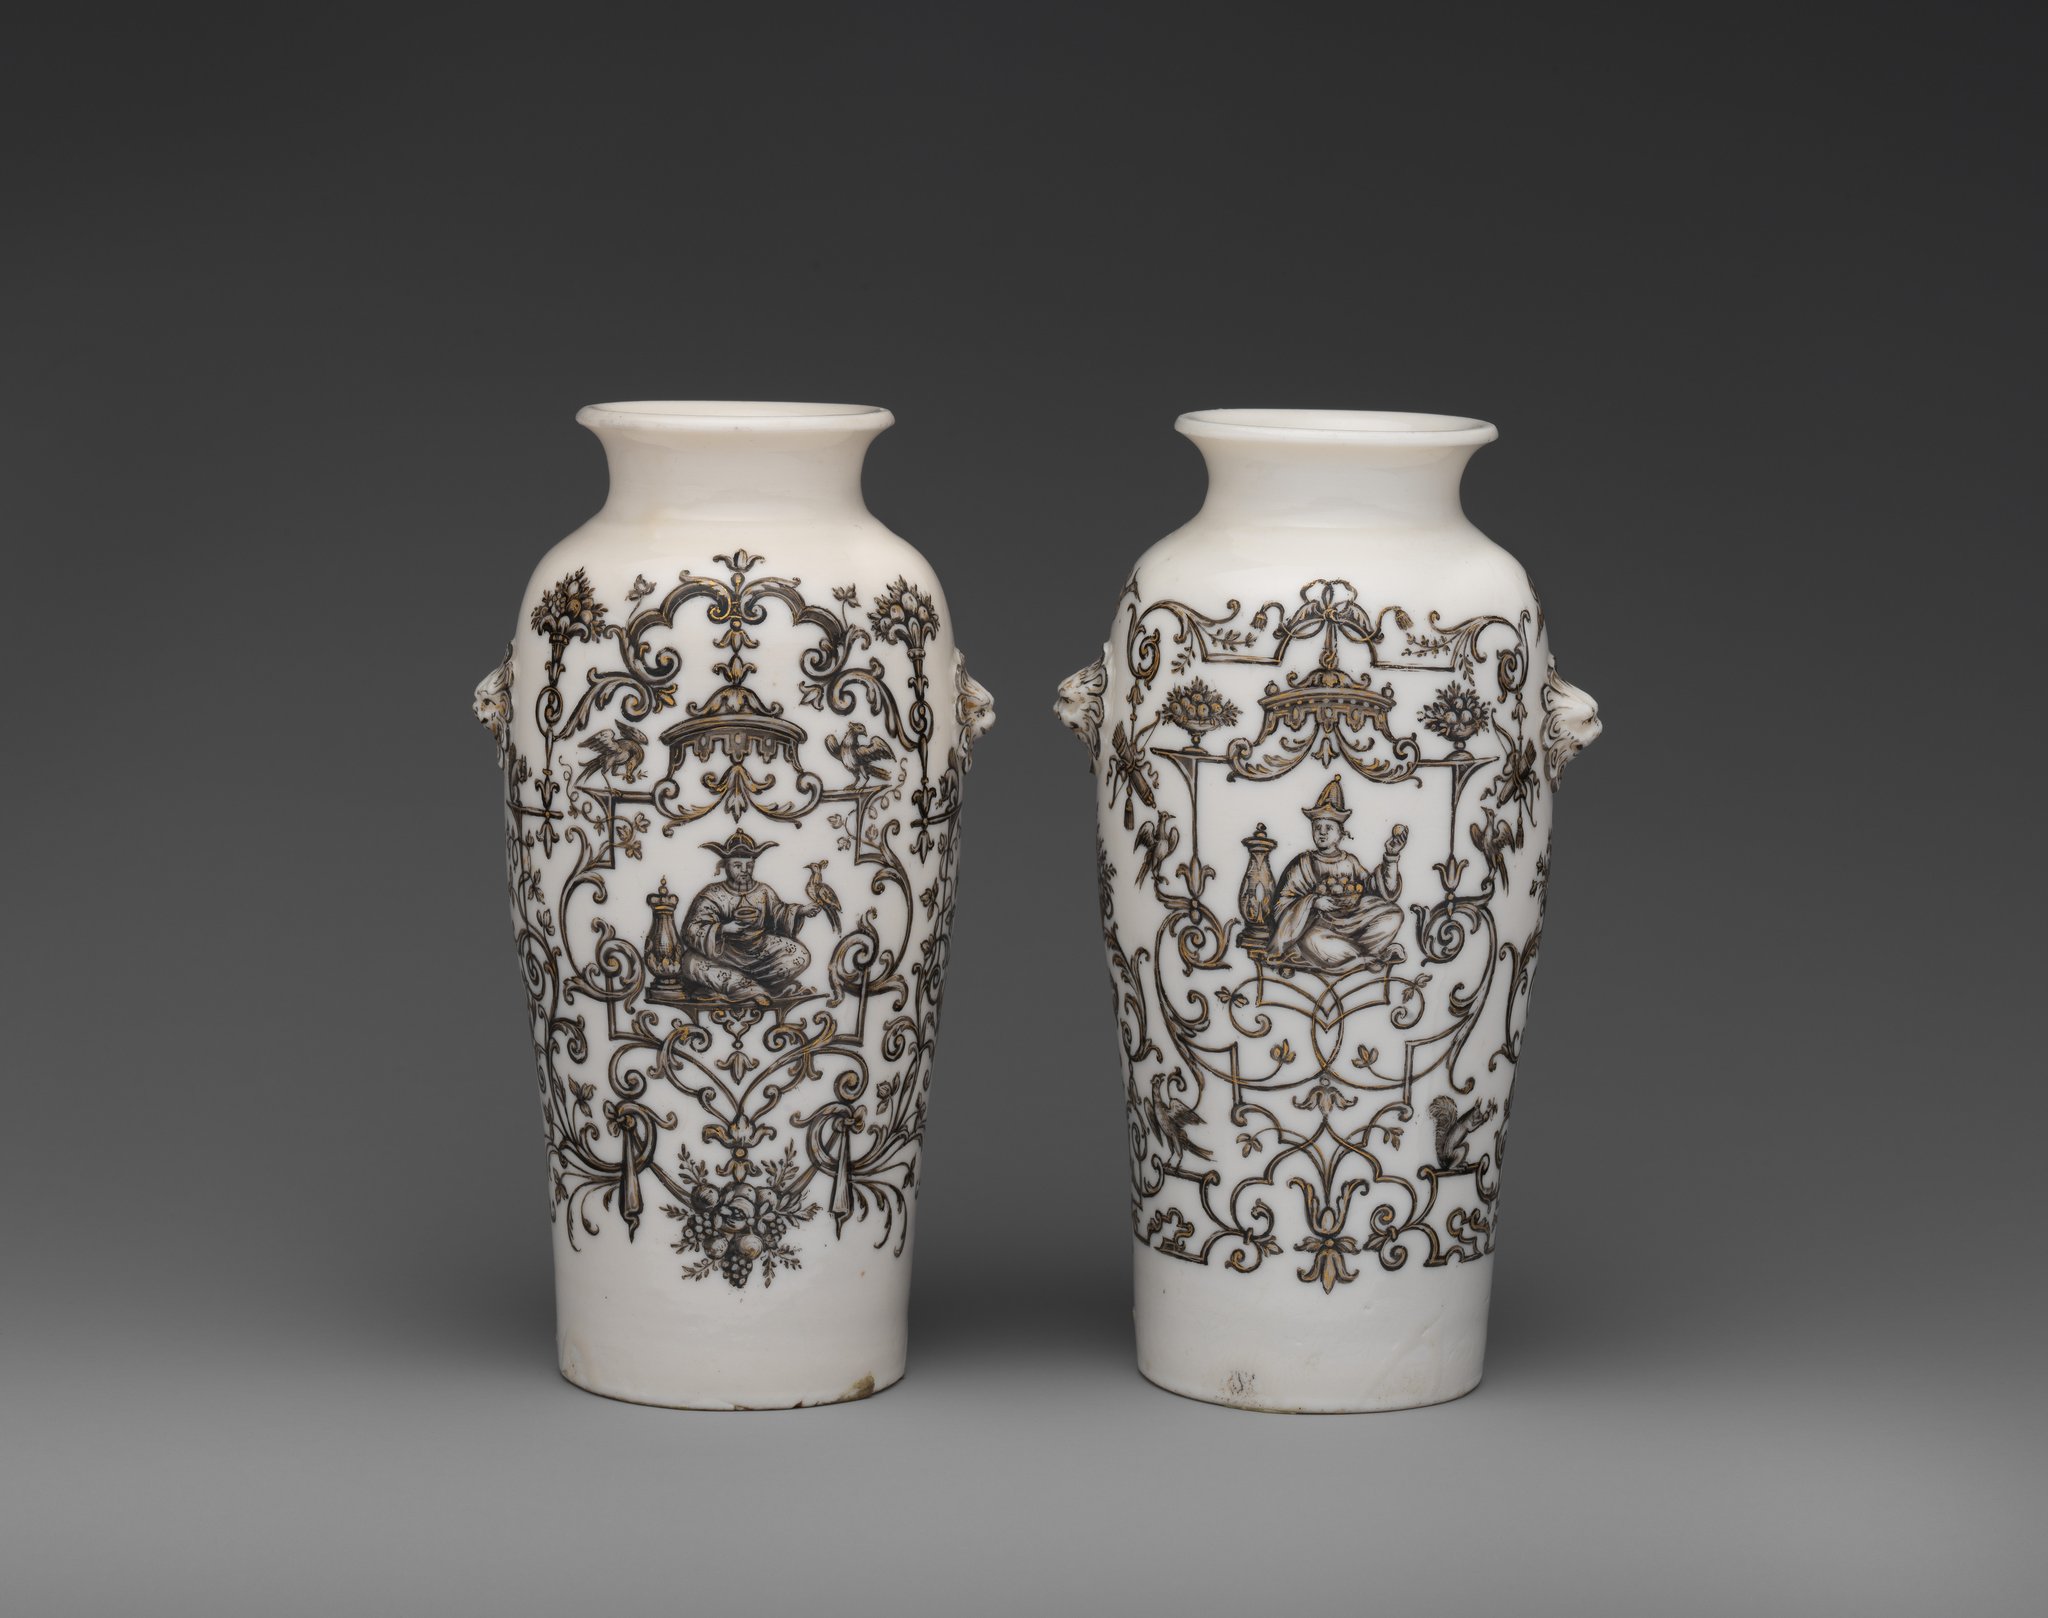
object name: vase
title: Pair of vases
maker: ignaz preissler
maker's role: decorator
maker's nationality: bohemian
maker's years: 1676-1741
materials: hard paste porcelain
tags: birds,men